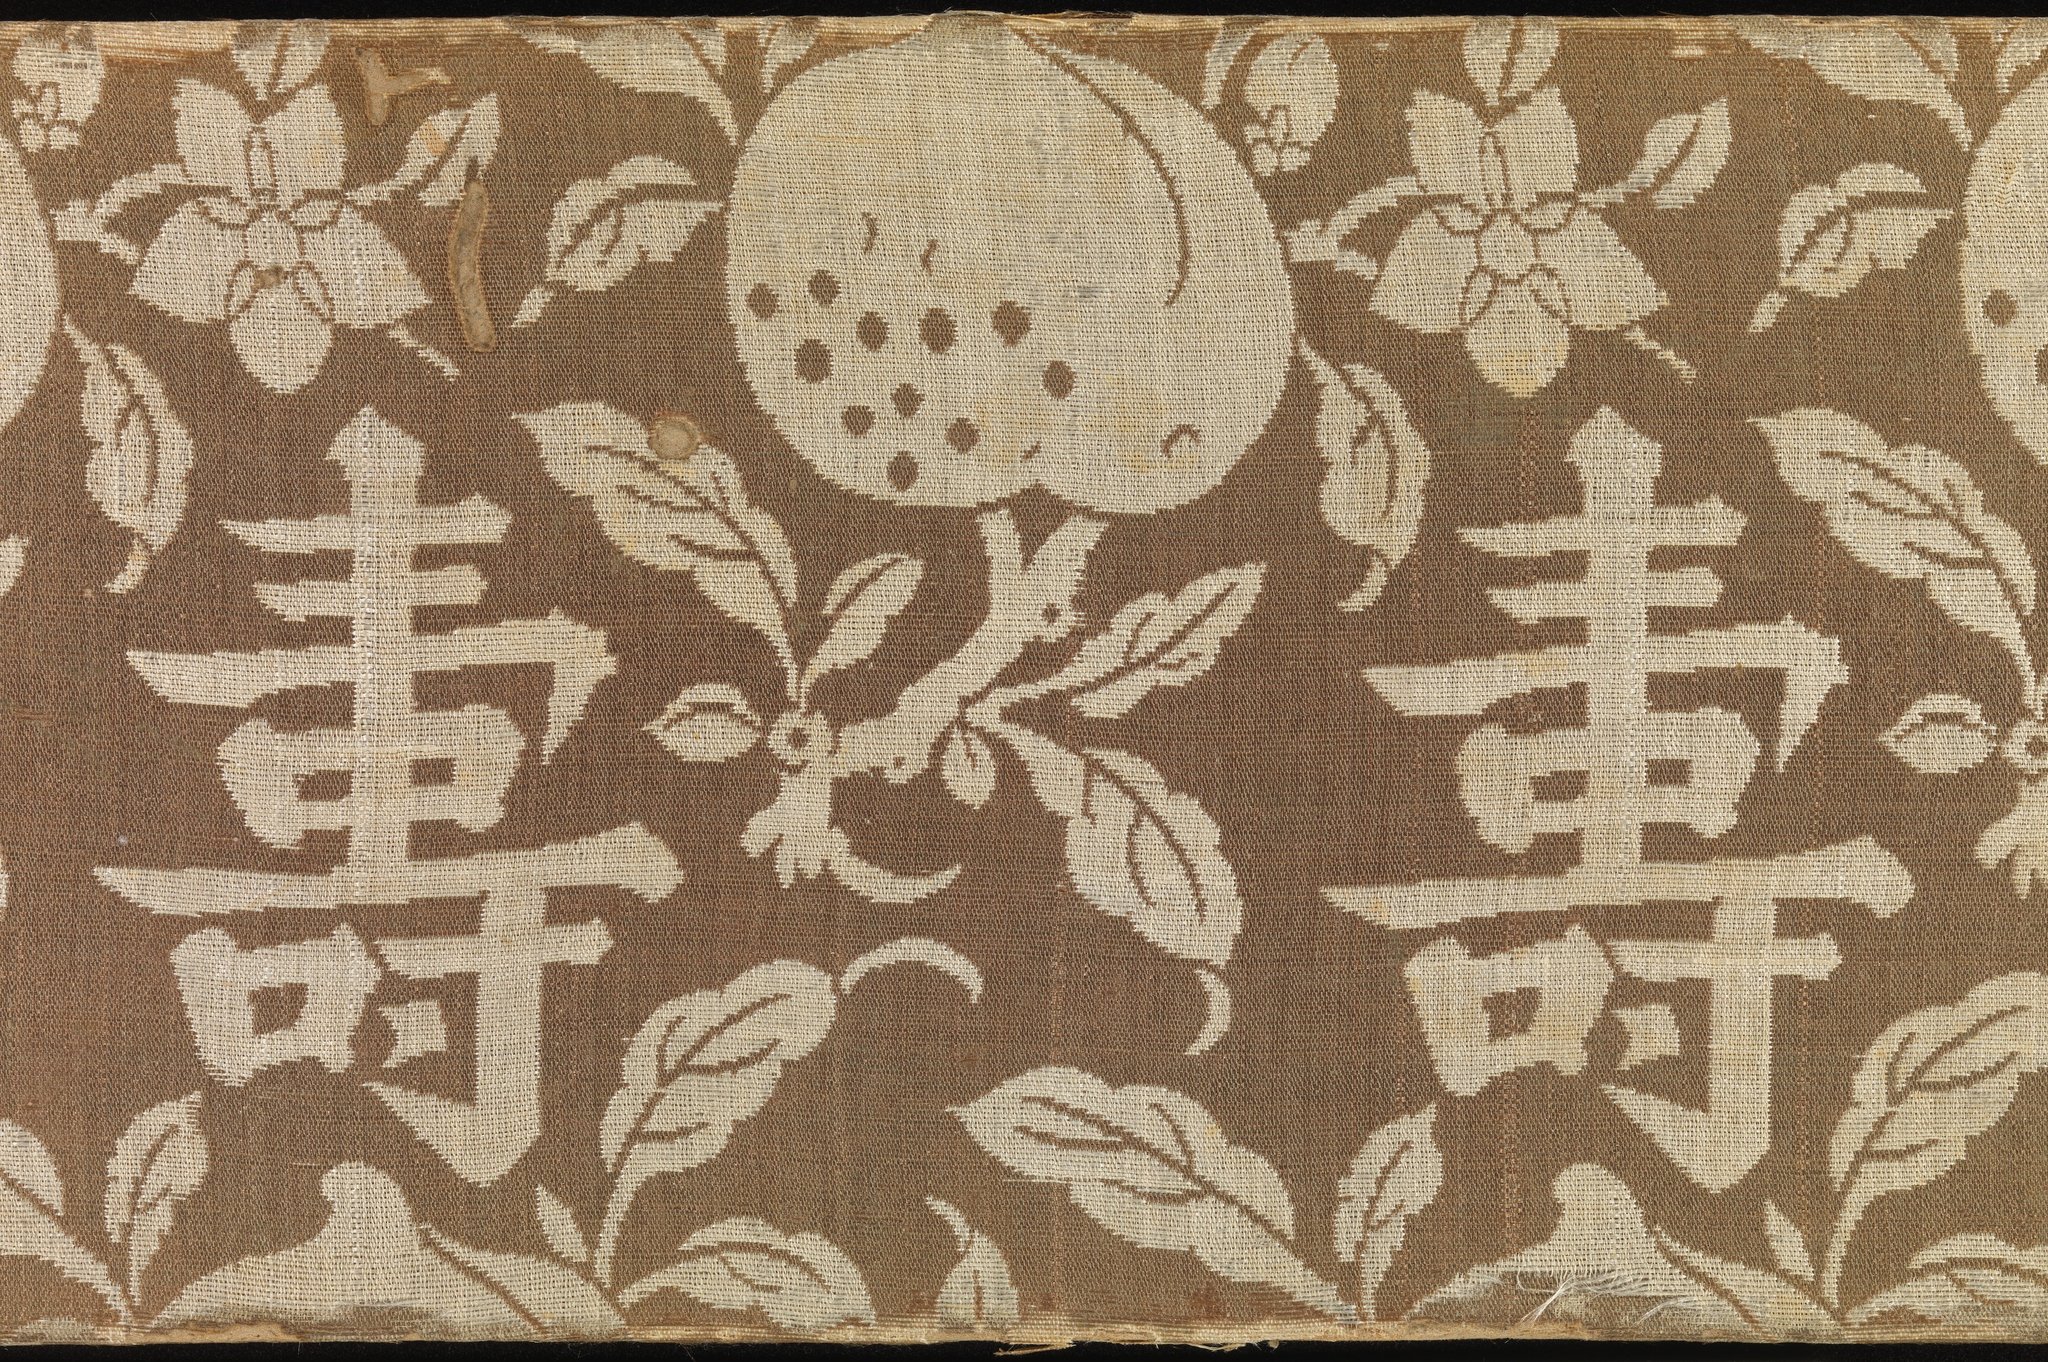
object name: sutra cover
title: Sutra Cover with Peaches and the Characters for Longevity (Shou)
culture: chinese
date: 1501-1600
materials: textile, silk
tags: fruit